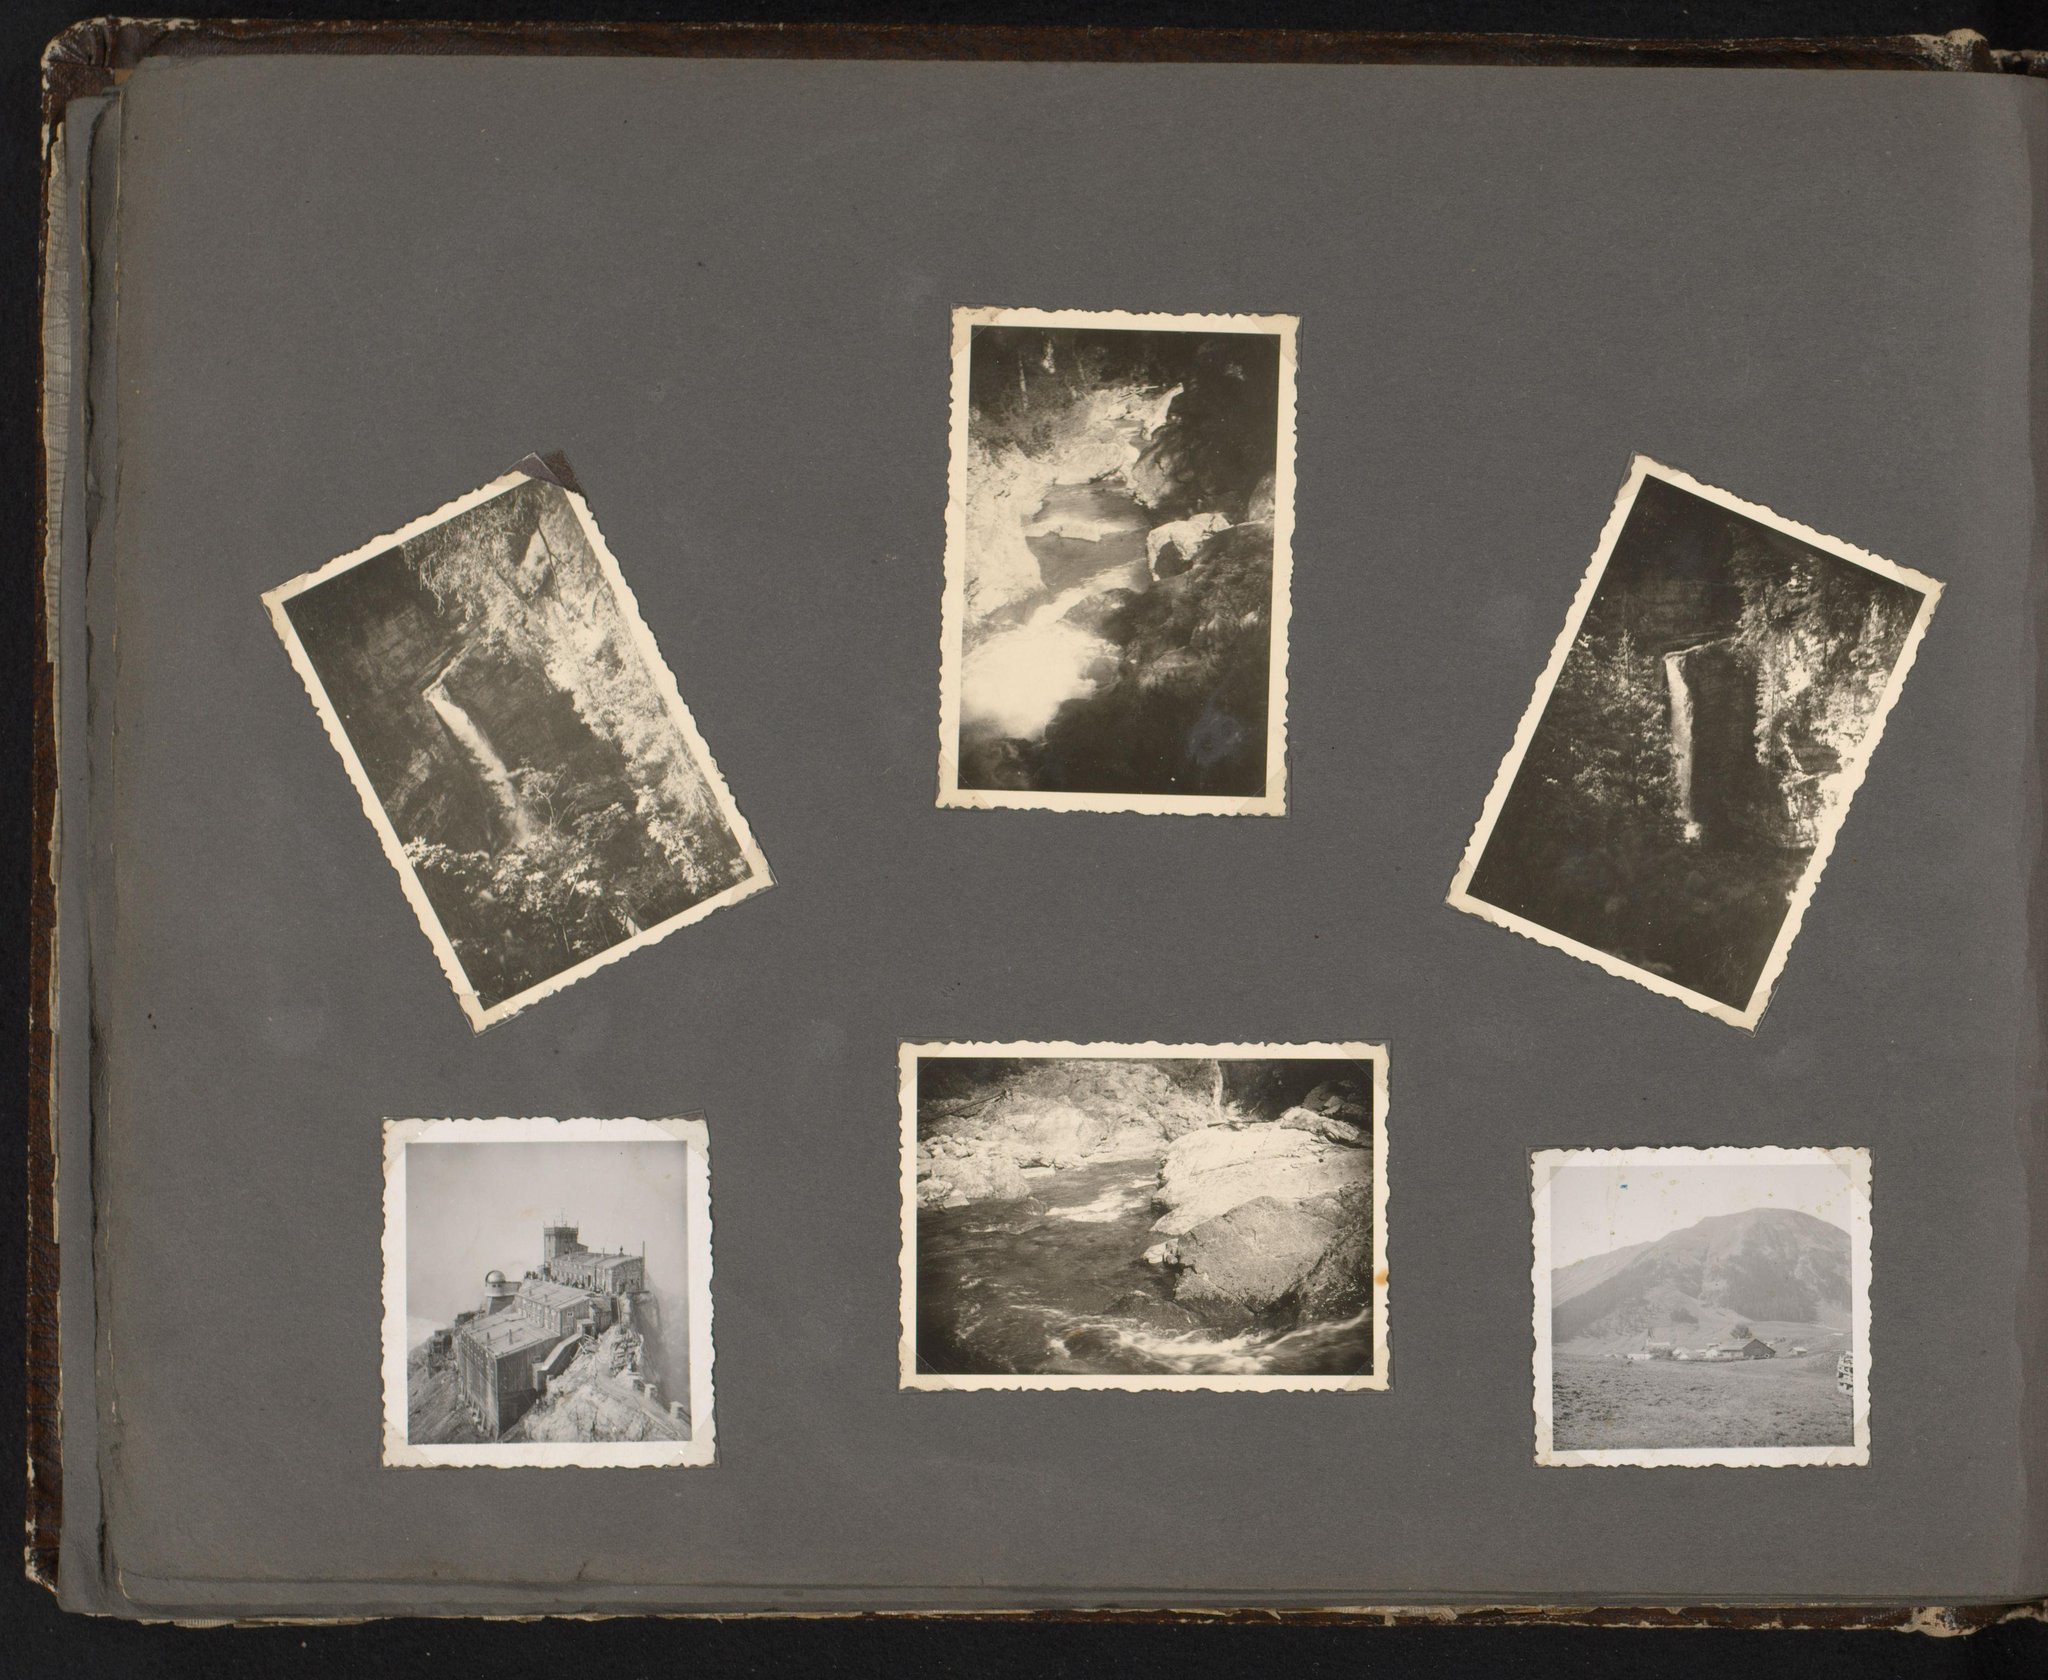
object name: photograph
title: Berglandschappen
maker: Anonymous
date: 1941-1945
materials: paper, photographic support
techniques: gelatin silver print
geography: alps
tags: waterfall, mountain-range, snow peaks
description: Albumblad met zes foto's van berglandschappen en watervallen, linksonder mogelijk waarnemingscentrum Gornergrat. Onderdeel van het fotoalbum Kriegsmarine.